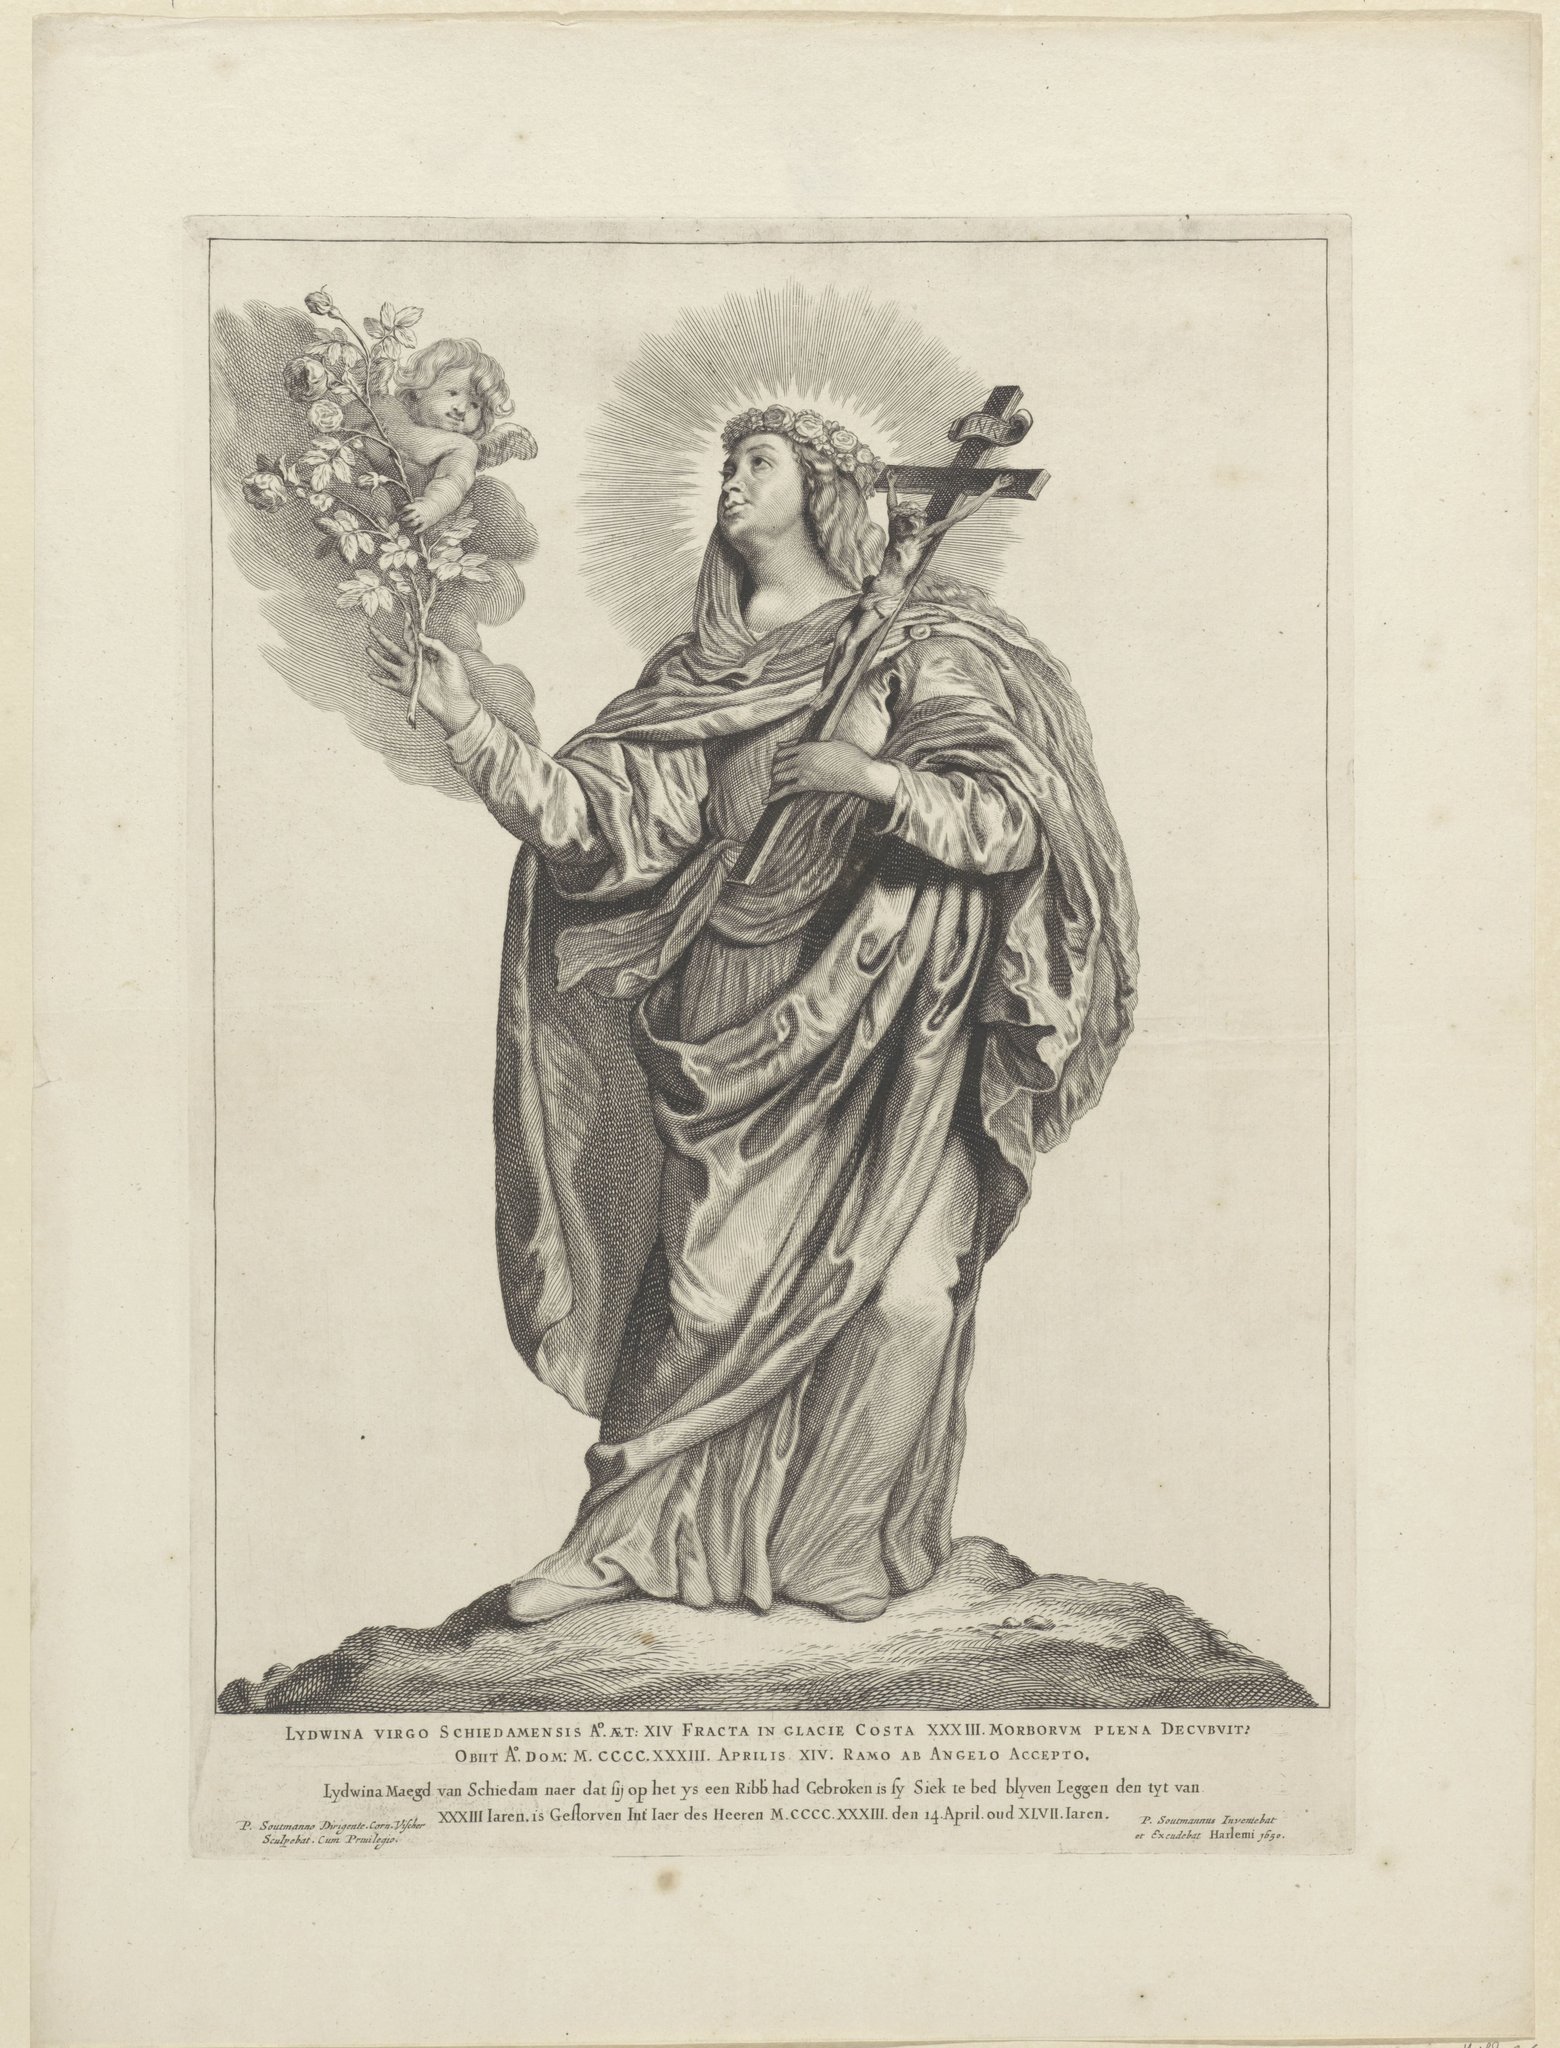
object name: print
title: H. Lidwina van Schiedam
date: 1650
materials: paper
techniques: engraving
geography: haarlem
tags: the virgin lidwyna (lydwine) of schiedam; possible attributes: crucifix, branch of roses in hand, roses in hair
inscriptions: collector's mark: Lugt 240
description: Deze prent maakt deel uit van de serie: Iesv Christo, Fideli Militantis Ecclesiae Imperatori, Liberali Eivsdem, Trivmphantis, Remvneratori, hos In Foederato Belgio Militiae Svae Legatos, Sanctissimos Sacri Belli Dvces, Patriae Apostolos, Et Decora Lvmina, Cvm Dvabvs Heroinis, Militans In Iisdem Provinciis Ecclesia. Haarlem: Pieter Claesz. Soutman, 1650.